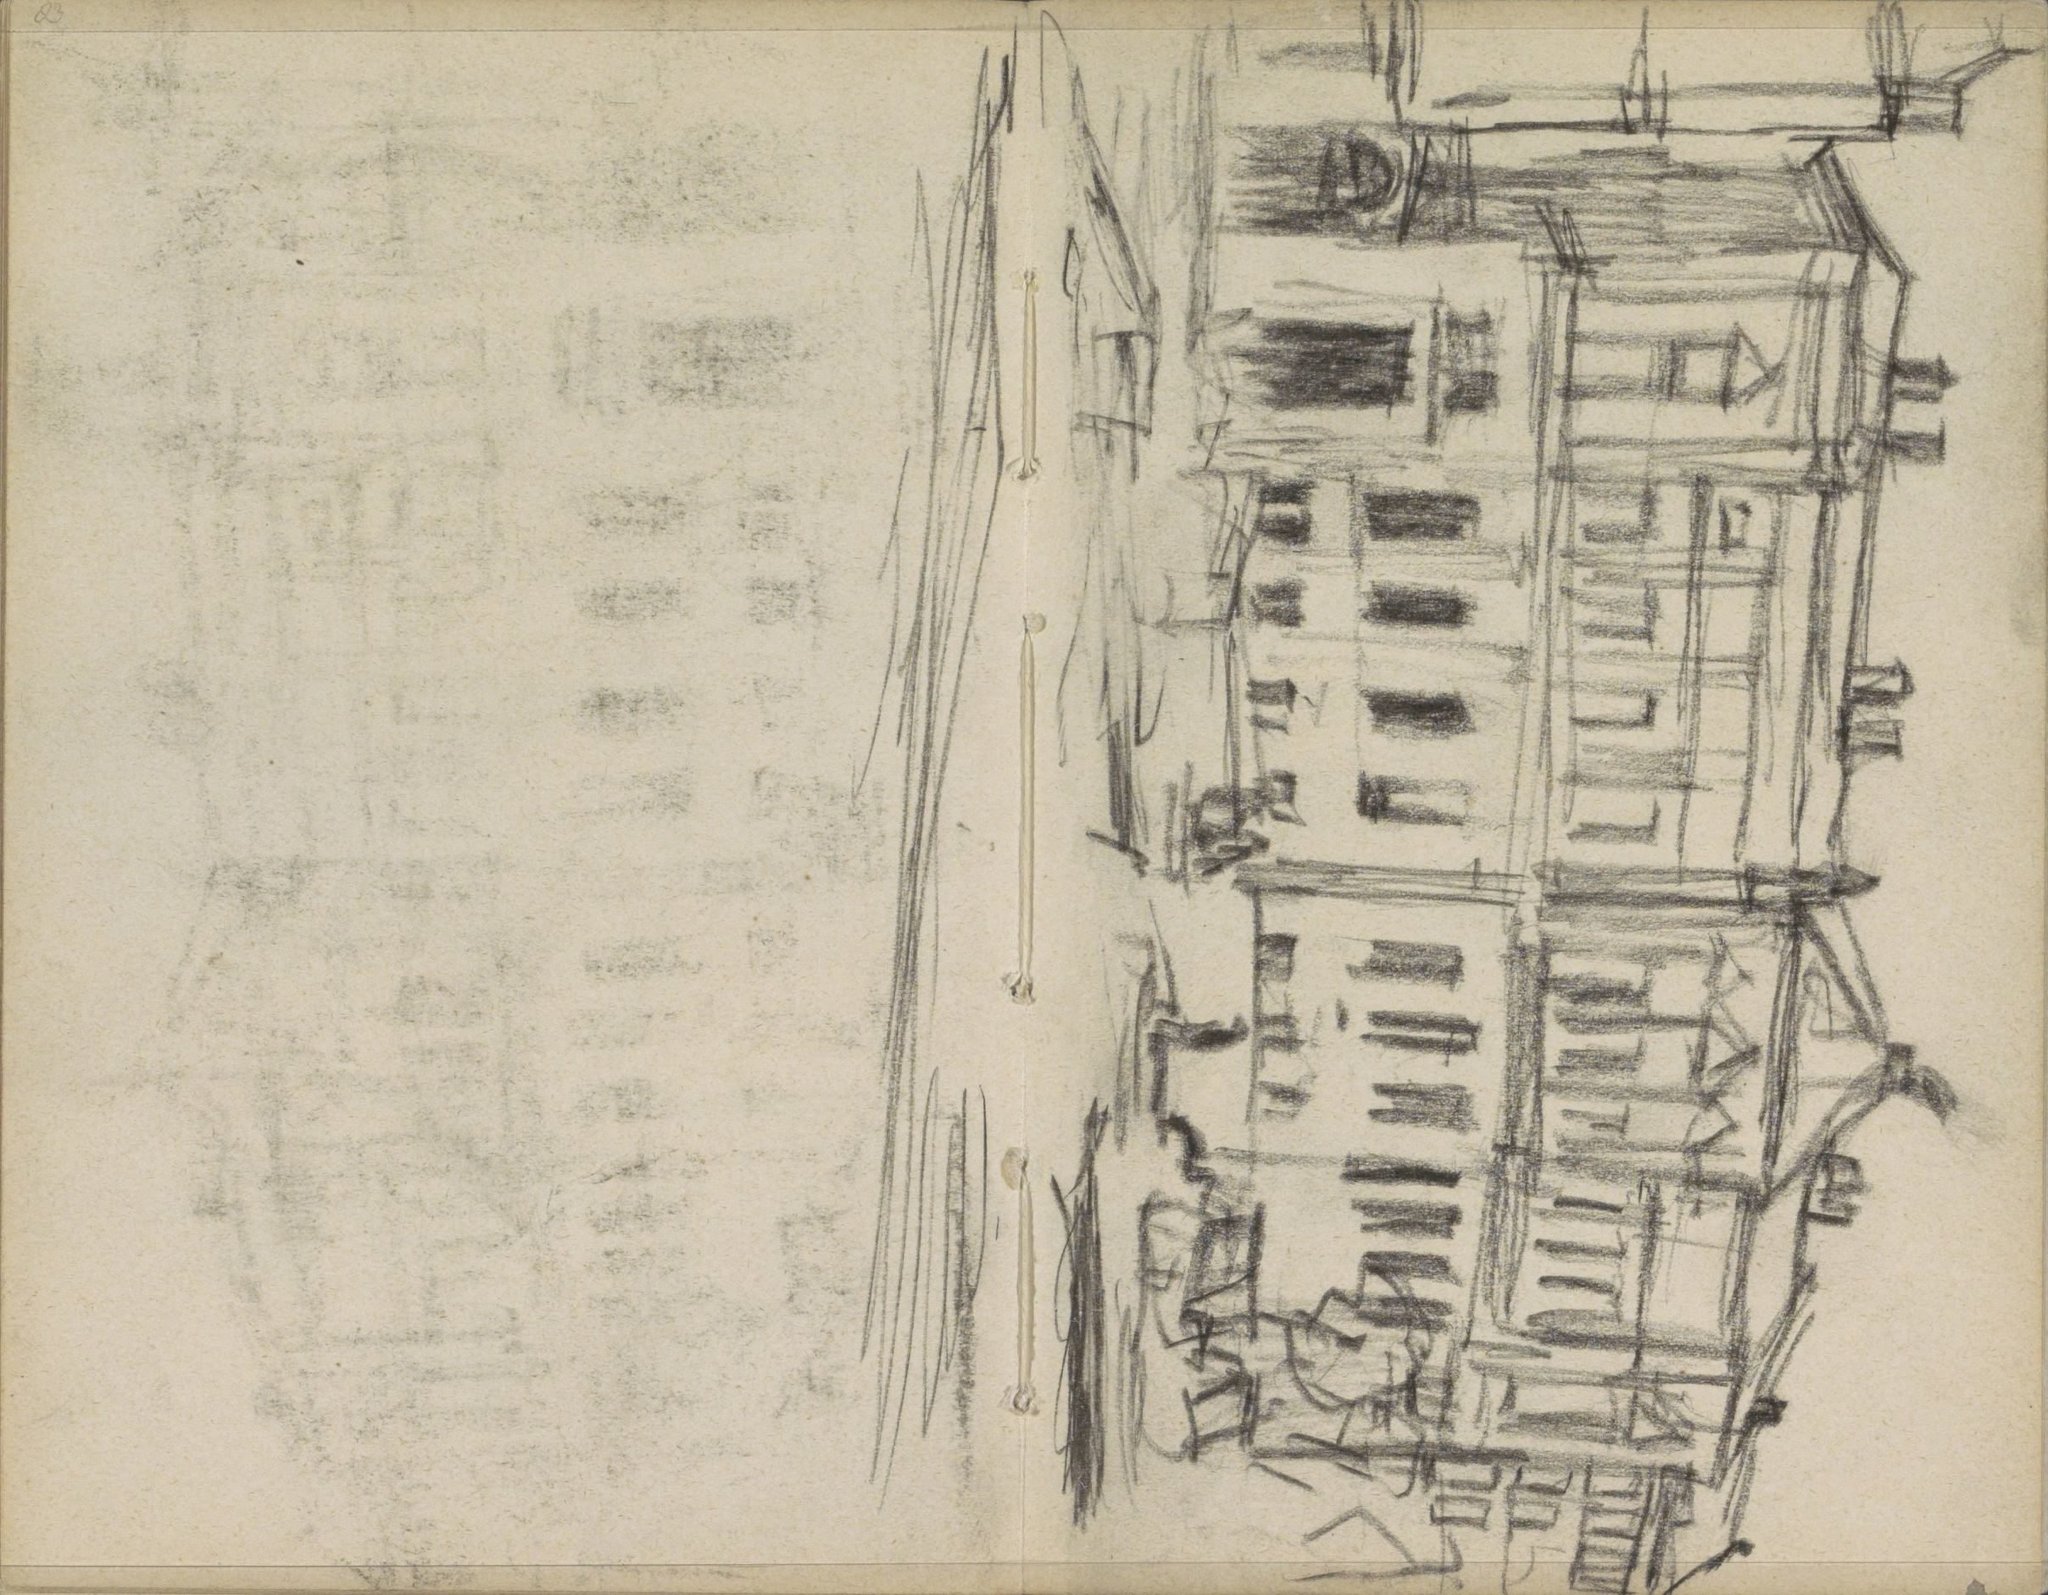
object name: sketchbook leaf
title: Gezicht op De Nederlandsche Bank aan de Oude Turfmarkt 127-129 te Amsterdam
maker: george hendrik breitner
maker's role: draughtsman, painter, print maker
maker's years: 1857-1923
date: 1900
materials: chalk, paper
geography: amsterdam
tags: civic architecture; edifices; dwellings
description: Pagina 83 en pagina 84 uit een schetsboek met 46 bladen.